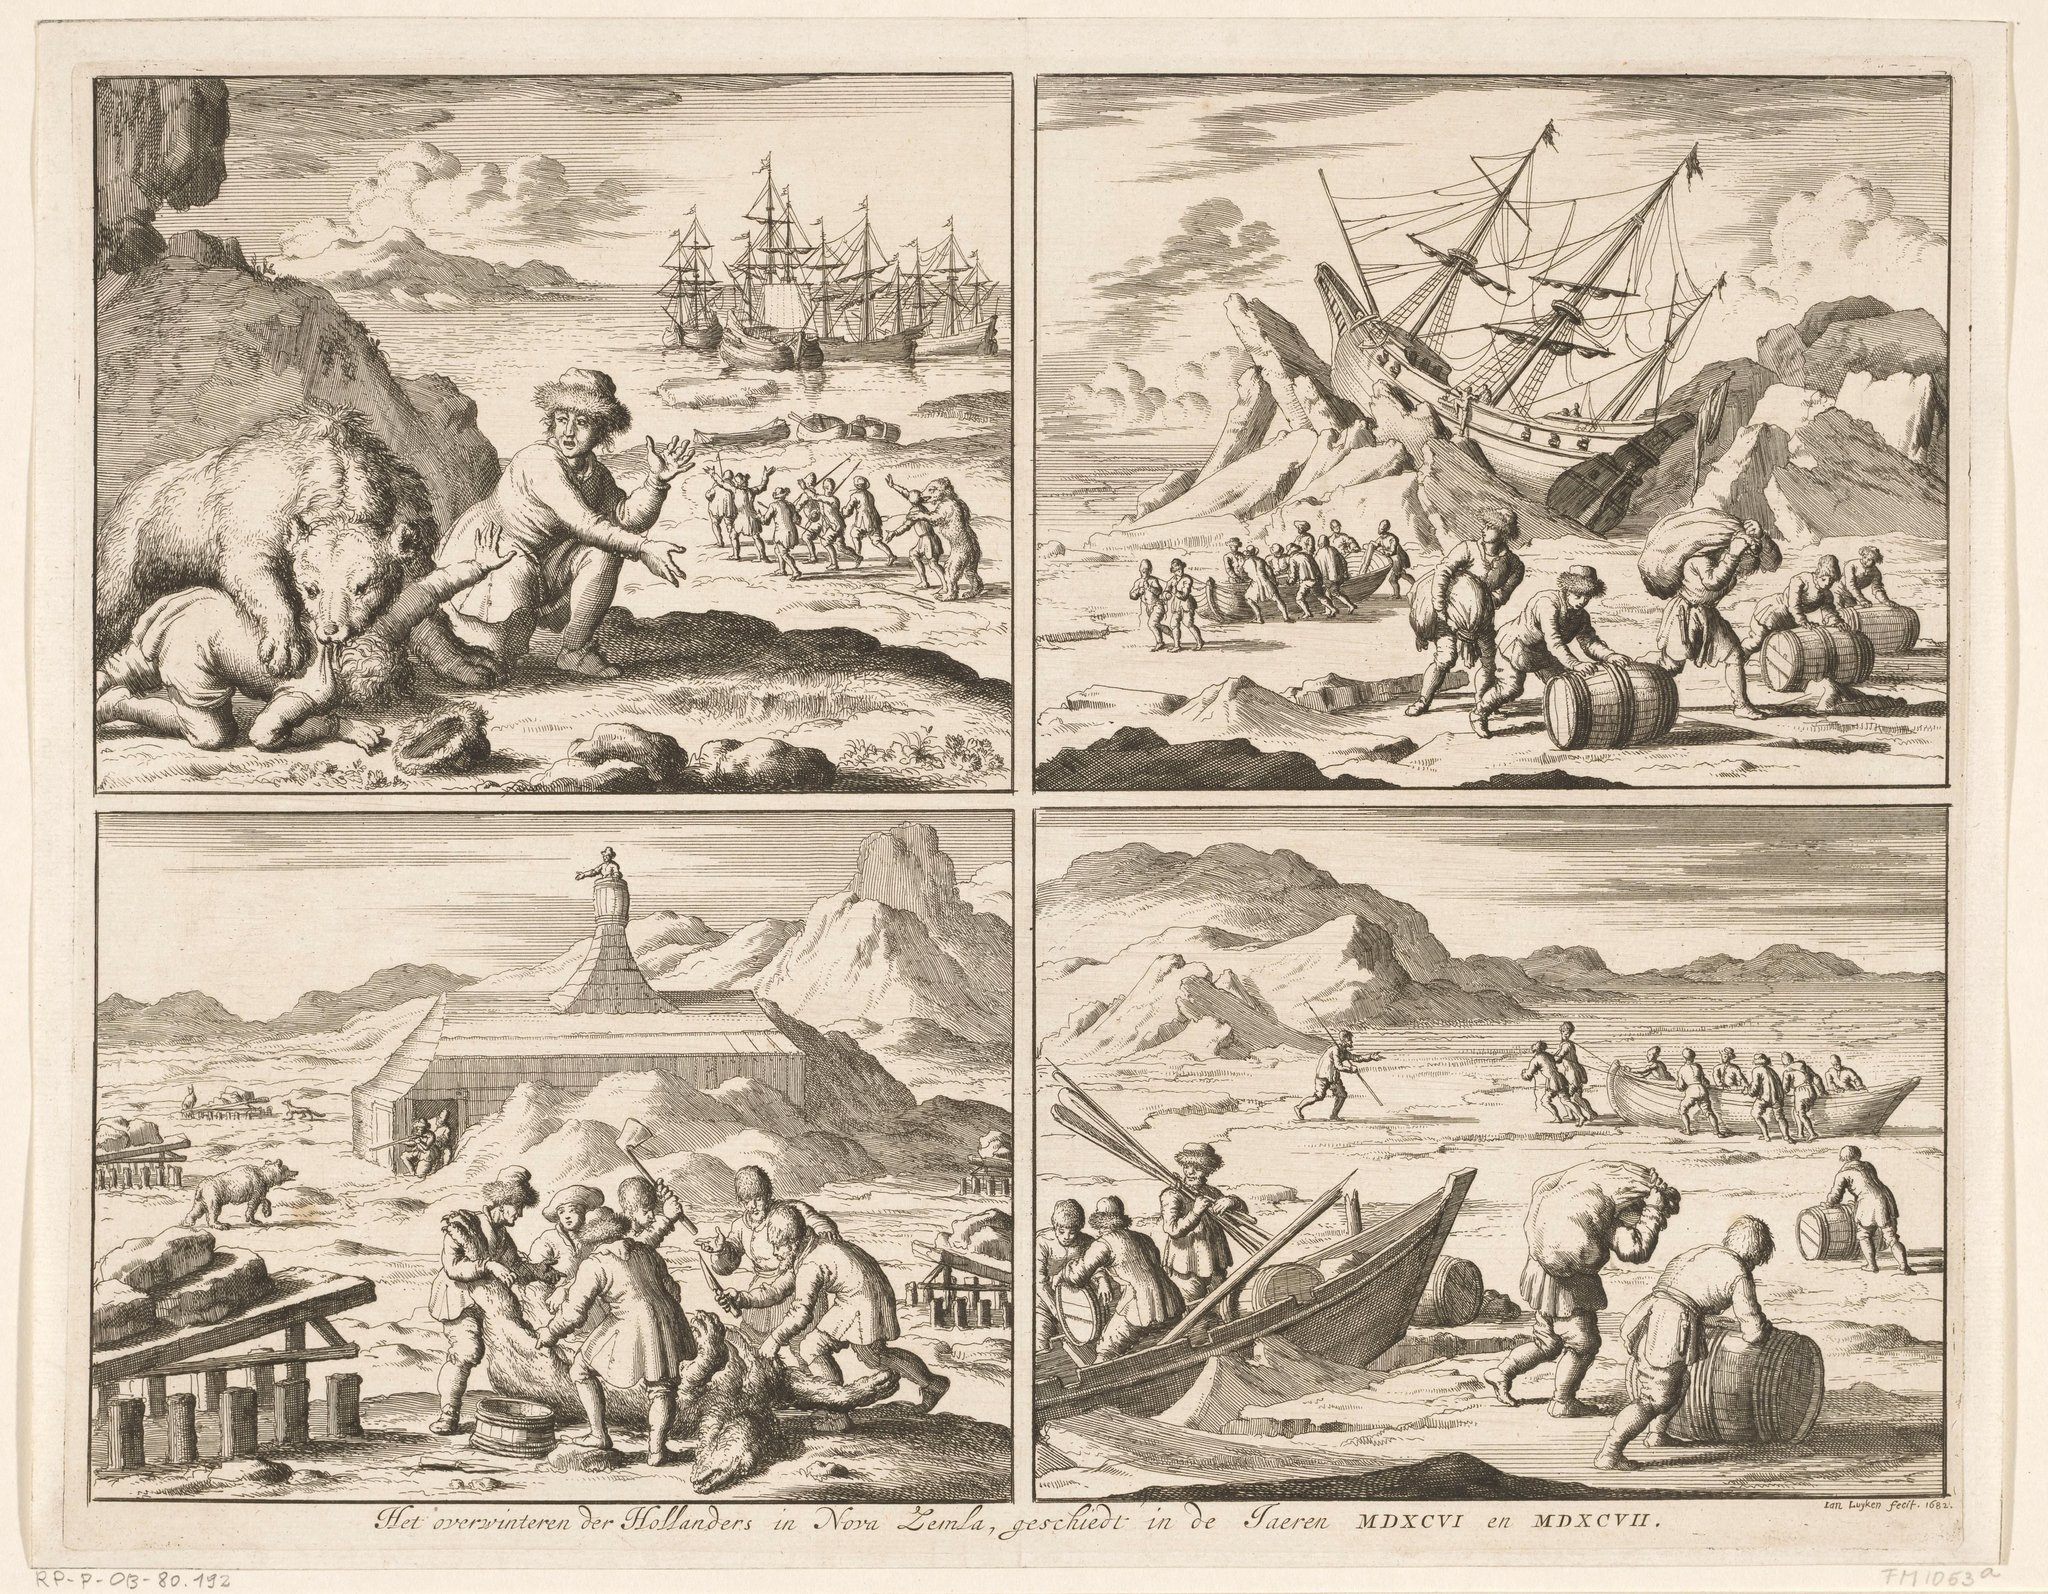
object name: print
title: Overwintering op Nova Zembla, 1596-1597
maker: jan luyken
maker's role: draughtsman, print maker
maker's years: 1649-1712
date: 1682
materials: paper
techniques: etching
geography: northern netherlands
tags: willem barendsz., amsterdam, jacob van heemskerck, beasts of prey, predatory animals: polar bear, island (in polar regions), icefield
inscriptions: date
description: Vier scènes uit de overwintering op Nova Zembla, 1596-1597. De bemanning aangevallen door ijsberen, het redden van goederen uit het schip, het schieten en slachten van een ijsbeer, het klaarmaken van de sloepen voor vertrek.